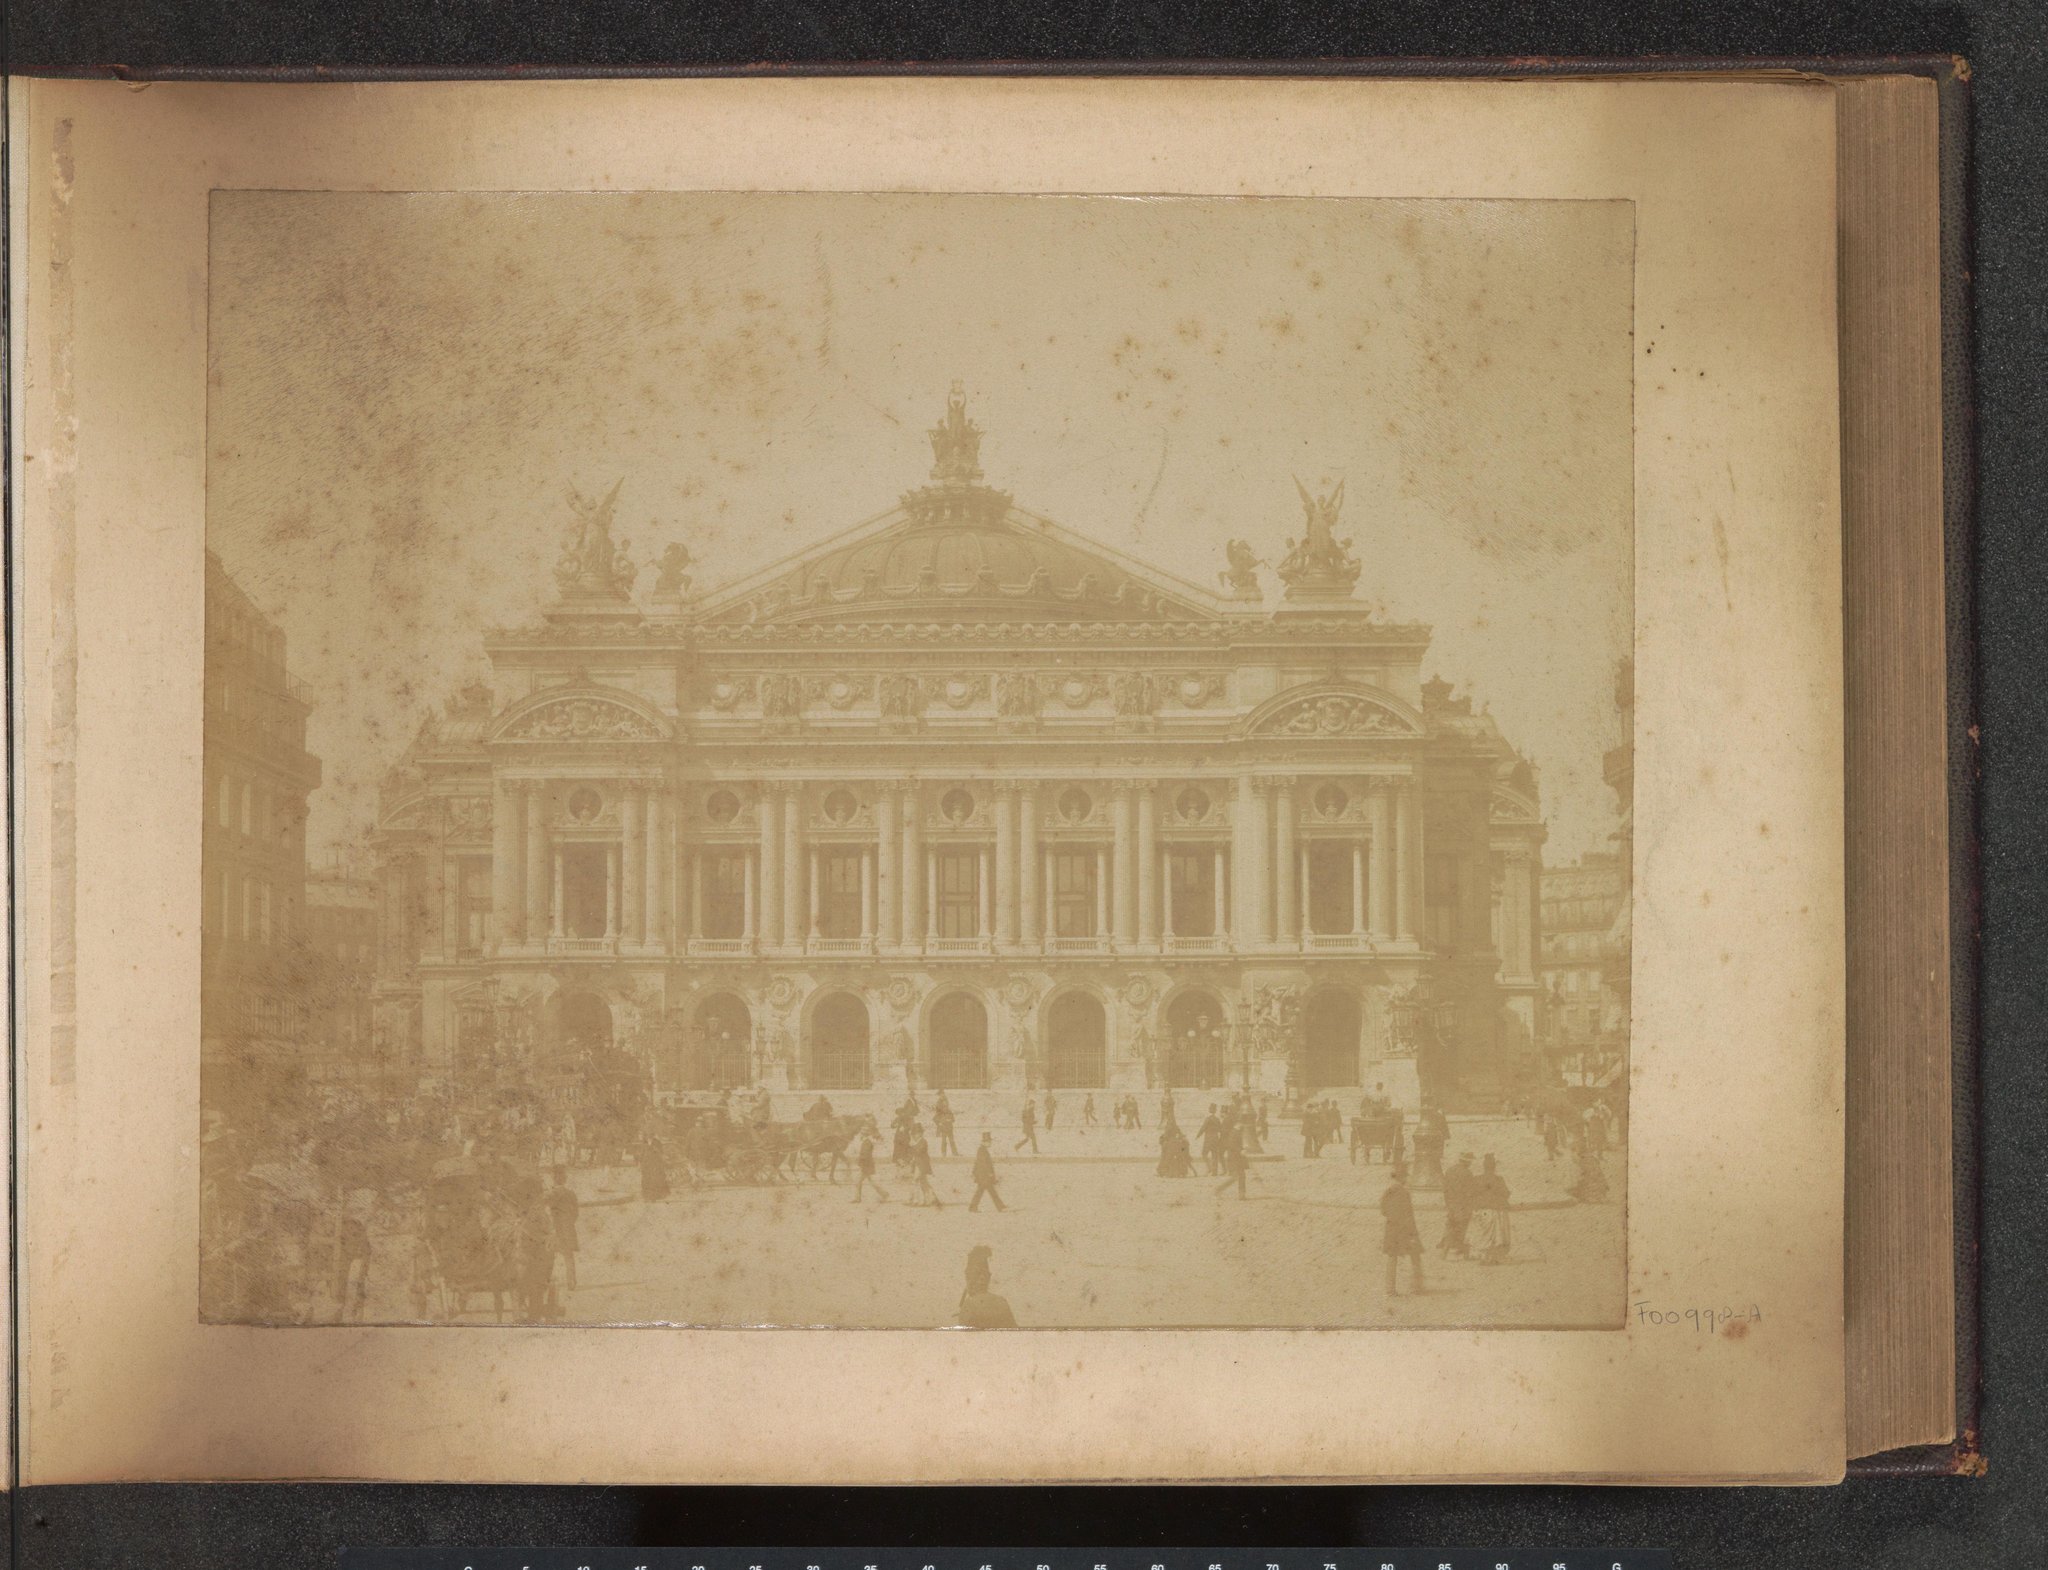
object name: photograph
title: Exterieur van de Opera van Parijs met koetsen en voorbijgangers ervoor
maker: Anonymous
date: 1880-1890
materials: paper, photographic support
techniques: albumen print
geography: paris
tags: opera house, paris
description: Onderdeel van Reisalbum met foto's van bezienswaardigheden in Frankrijk, Griekenland en Turkije.